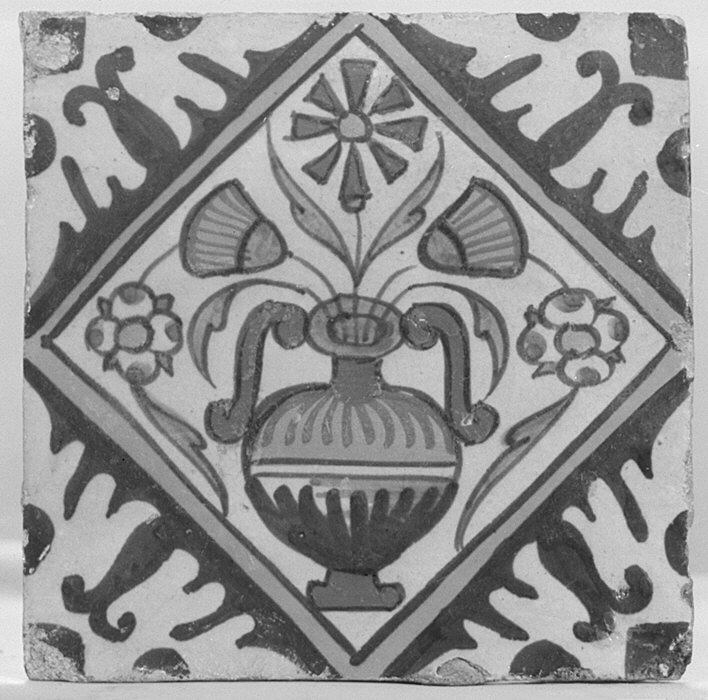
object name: tile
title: Tiles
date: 1580-1625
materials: earthenware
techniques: glazing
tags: flowers